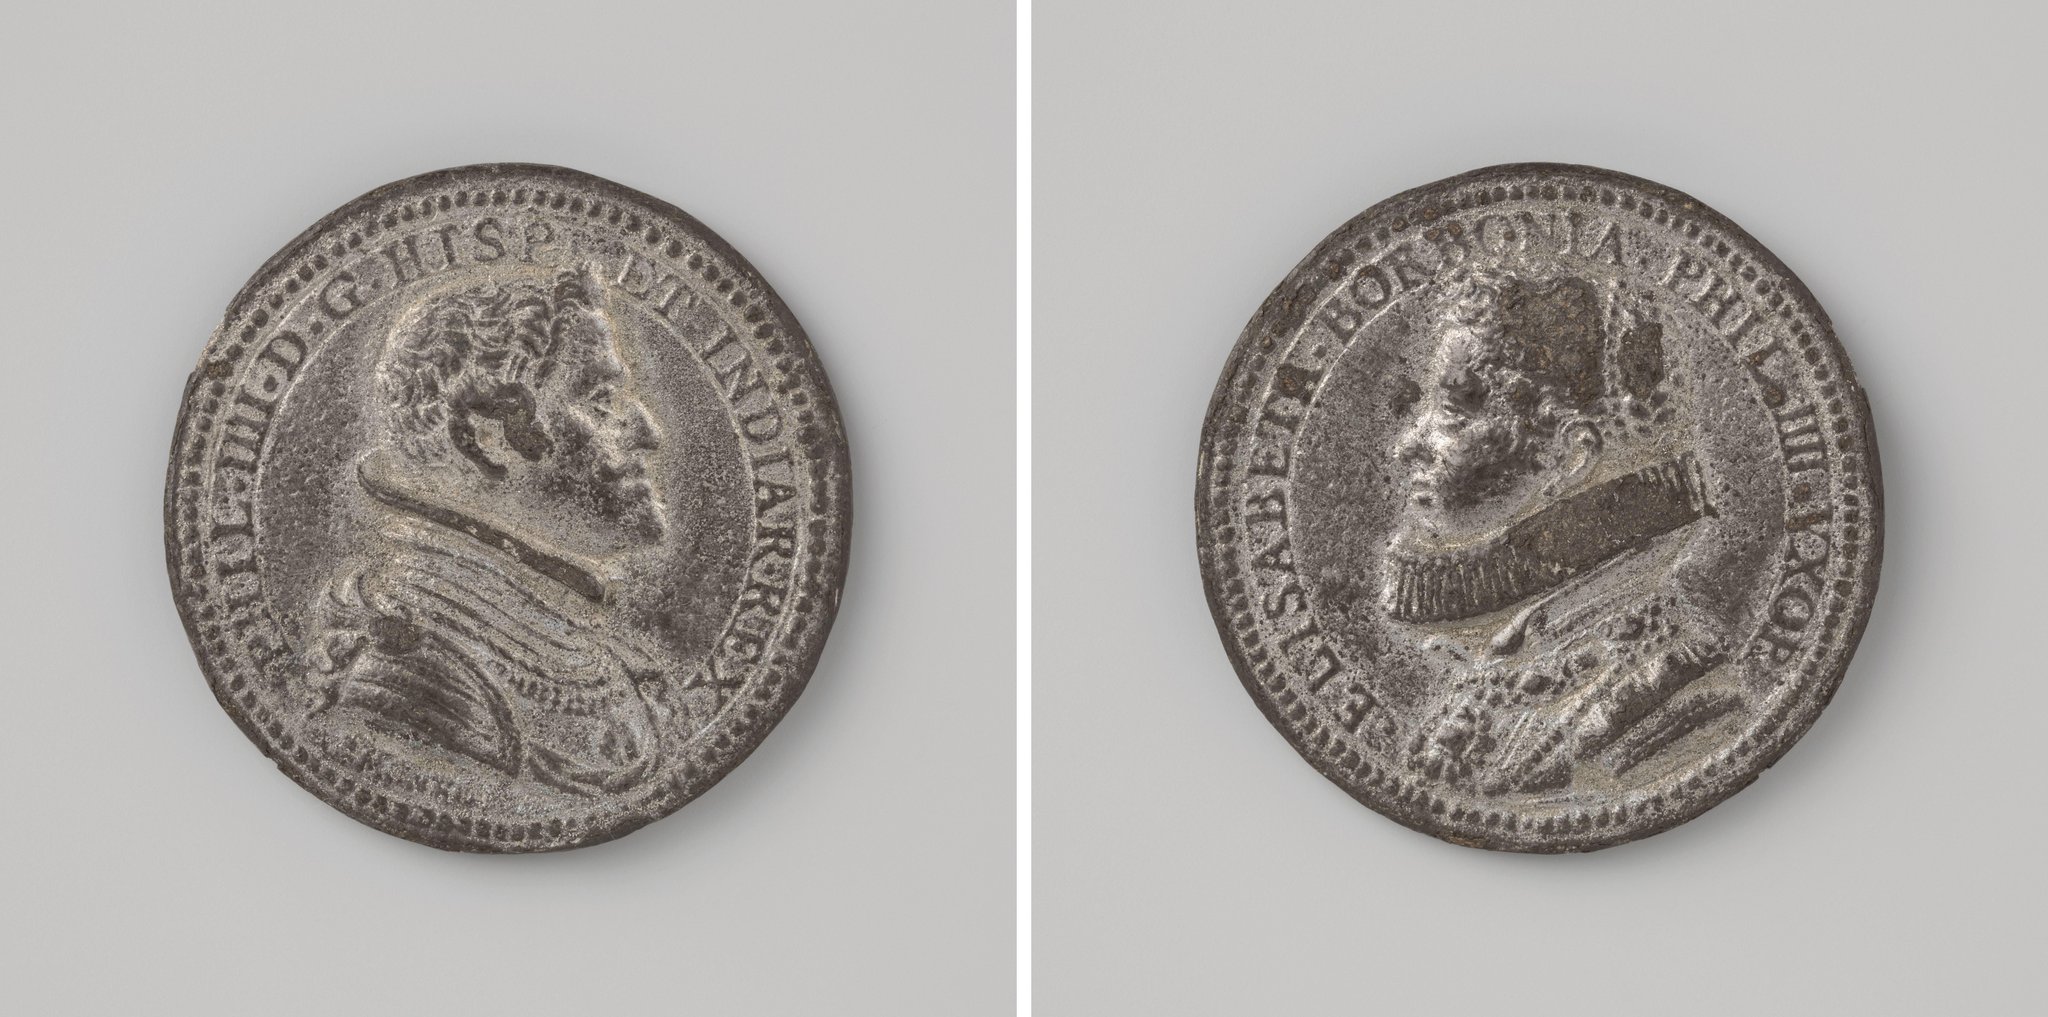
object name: history medal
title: Huwelijk van Philips IV Koning van Spanje met Elisabeth van Frankrijk 1615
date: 1615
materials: tin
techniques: casting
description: Tinnen penning, op de voorzijde het geharnaste borstbeeld van Philips naar rechts met omschrift, op de keerzijde het borstbeeld van Elisabeth naar links met omschrift.